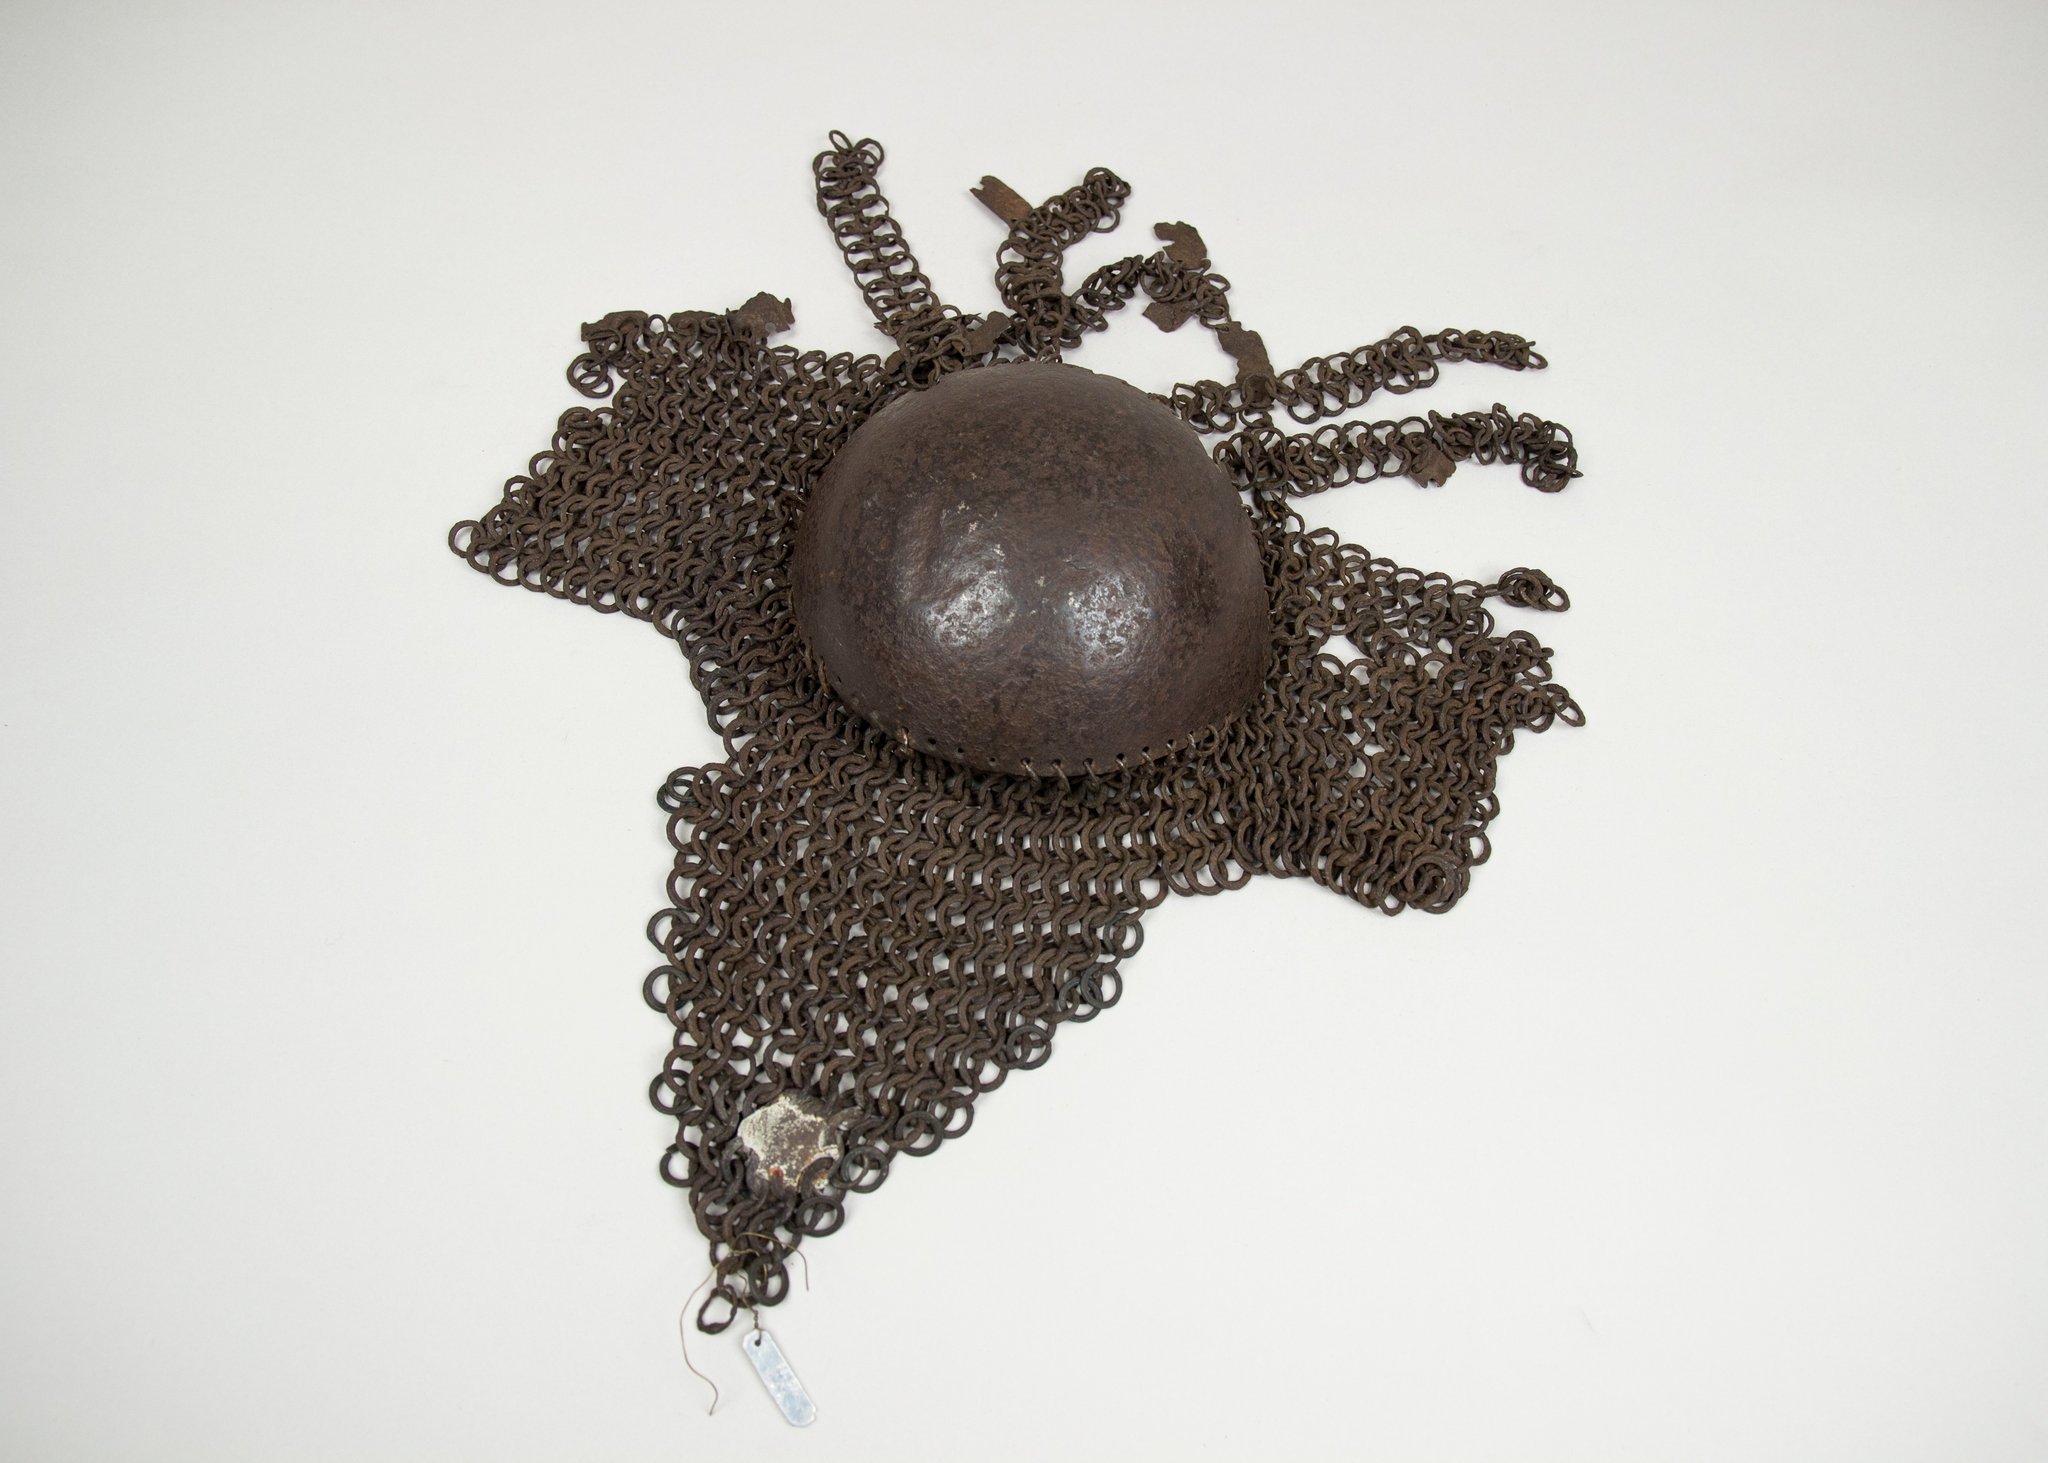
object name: thigh defense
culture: turkish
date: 1401-1500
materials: iron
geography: turkey